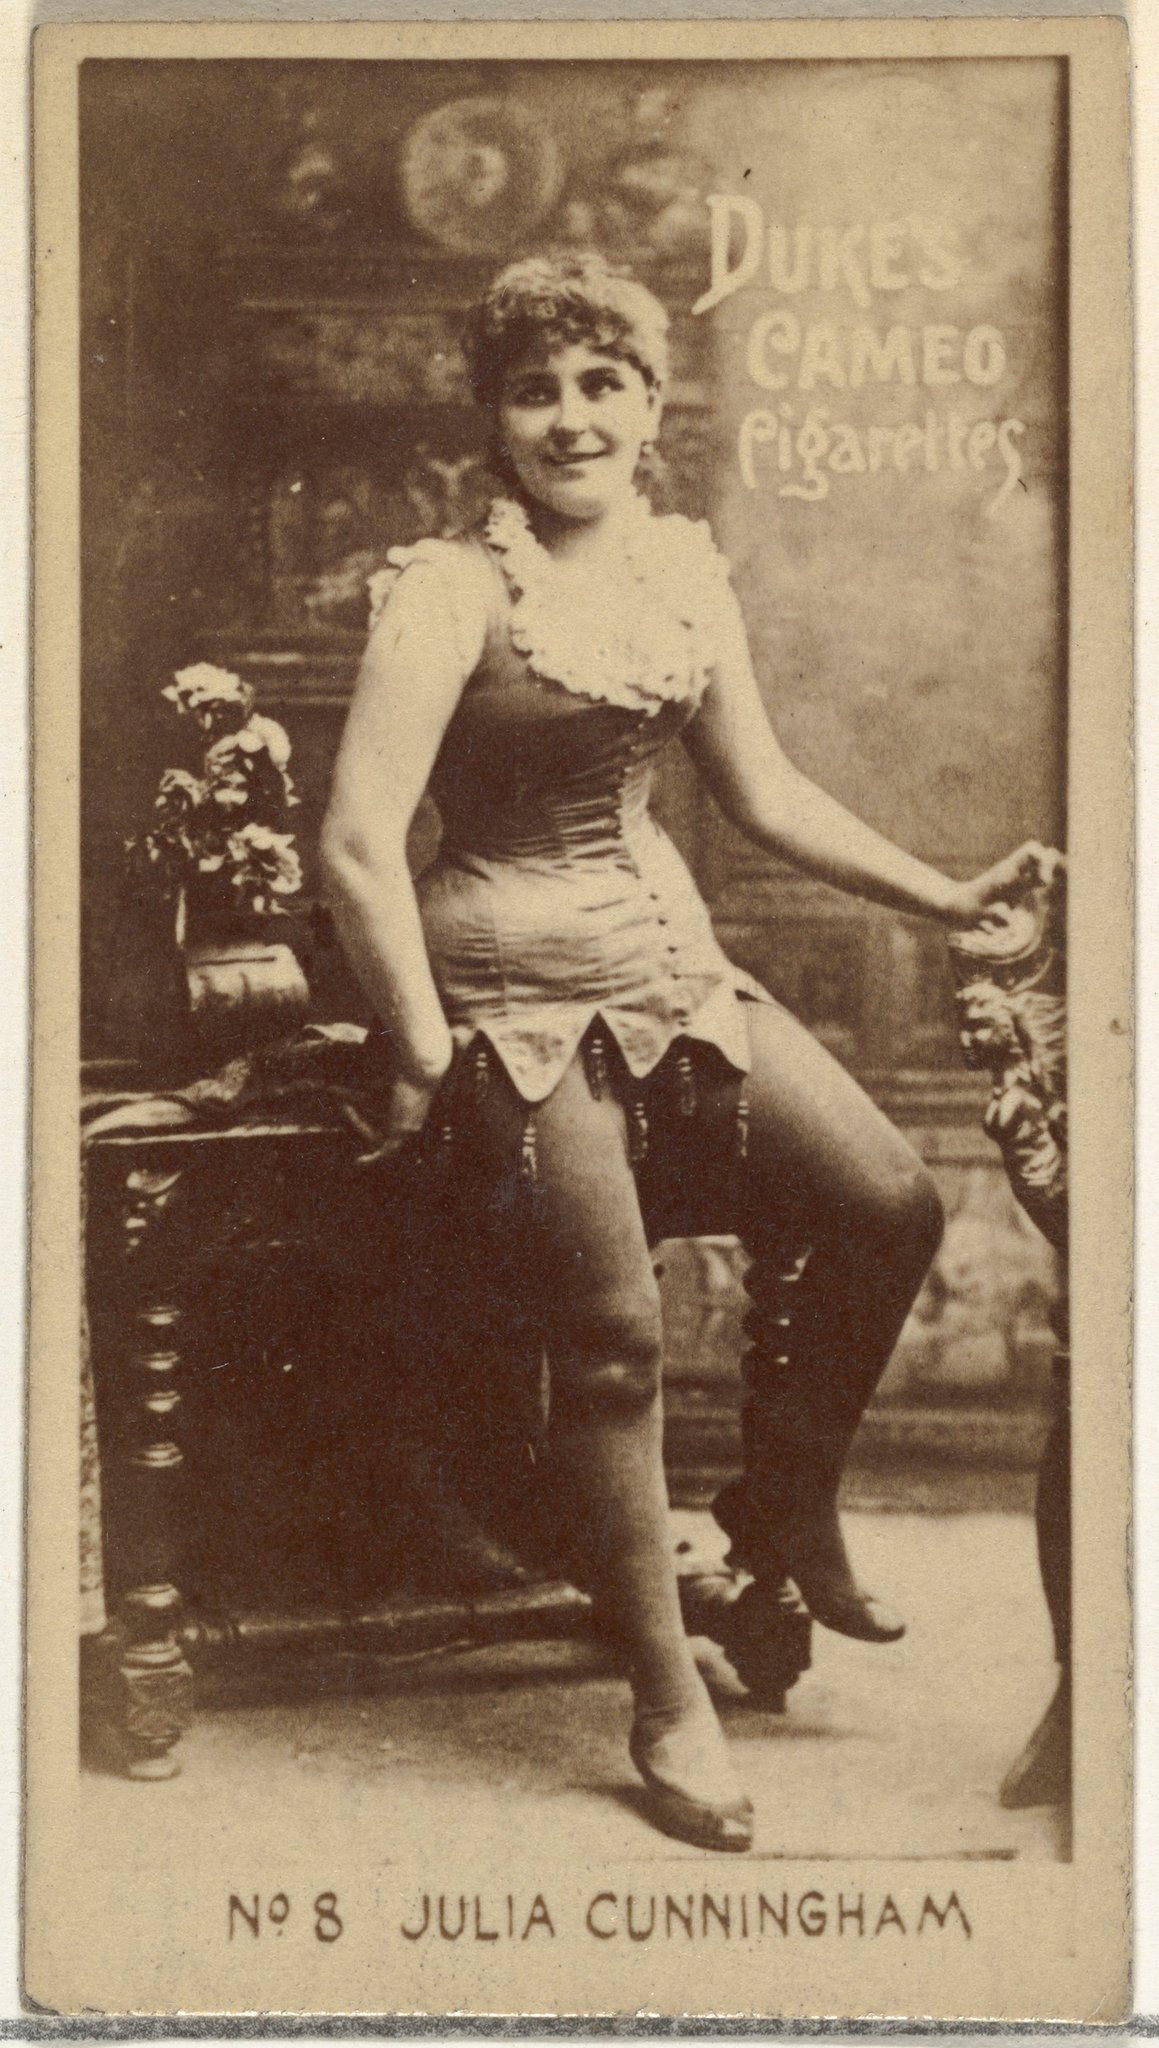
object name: photograph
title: Card Number 8, Julia Cunningham, from the Actors and Actresses series (N145-4) issued by Duke Sons & Co. to promote Cameo Cigarettes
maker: w. duke, sons & co.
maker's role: publisher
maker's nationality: american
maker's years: 1870-1920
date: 1880-1889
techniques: albumen silver print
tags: portraits,women,actresses